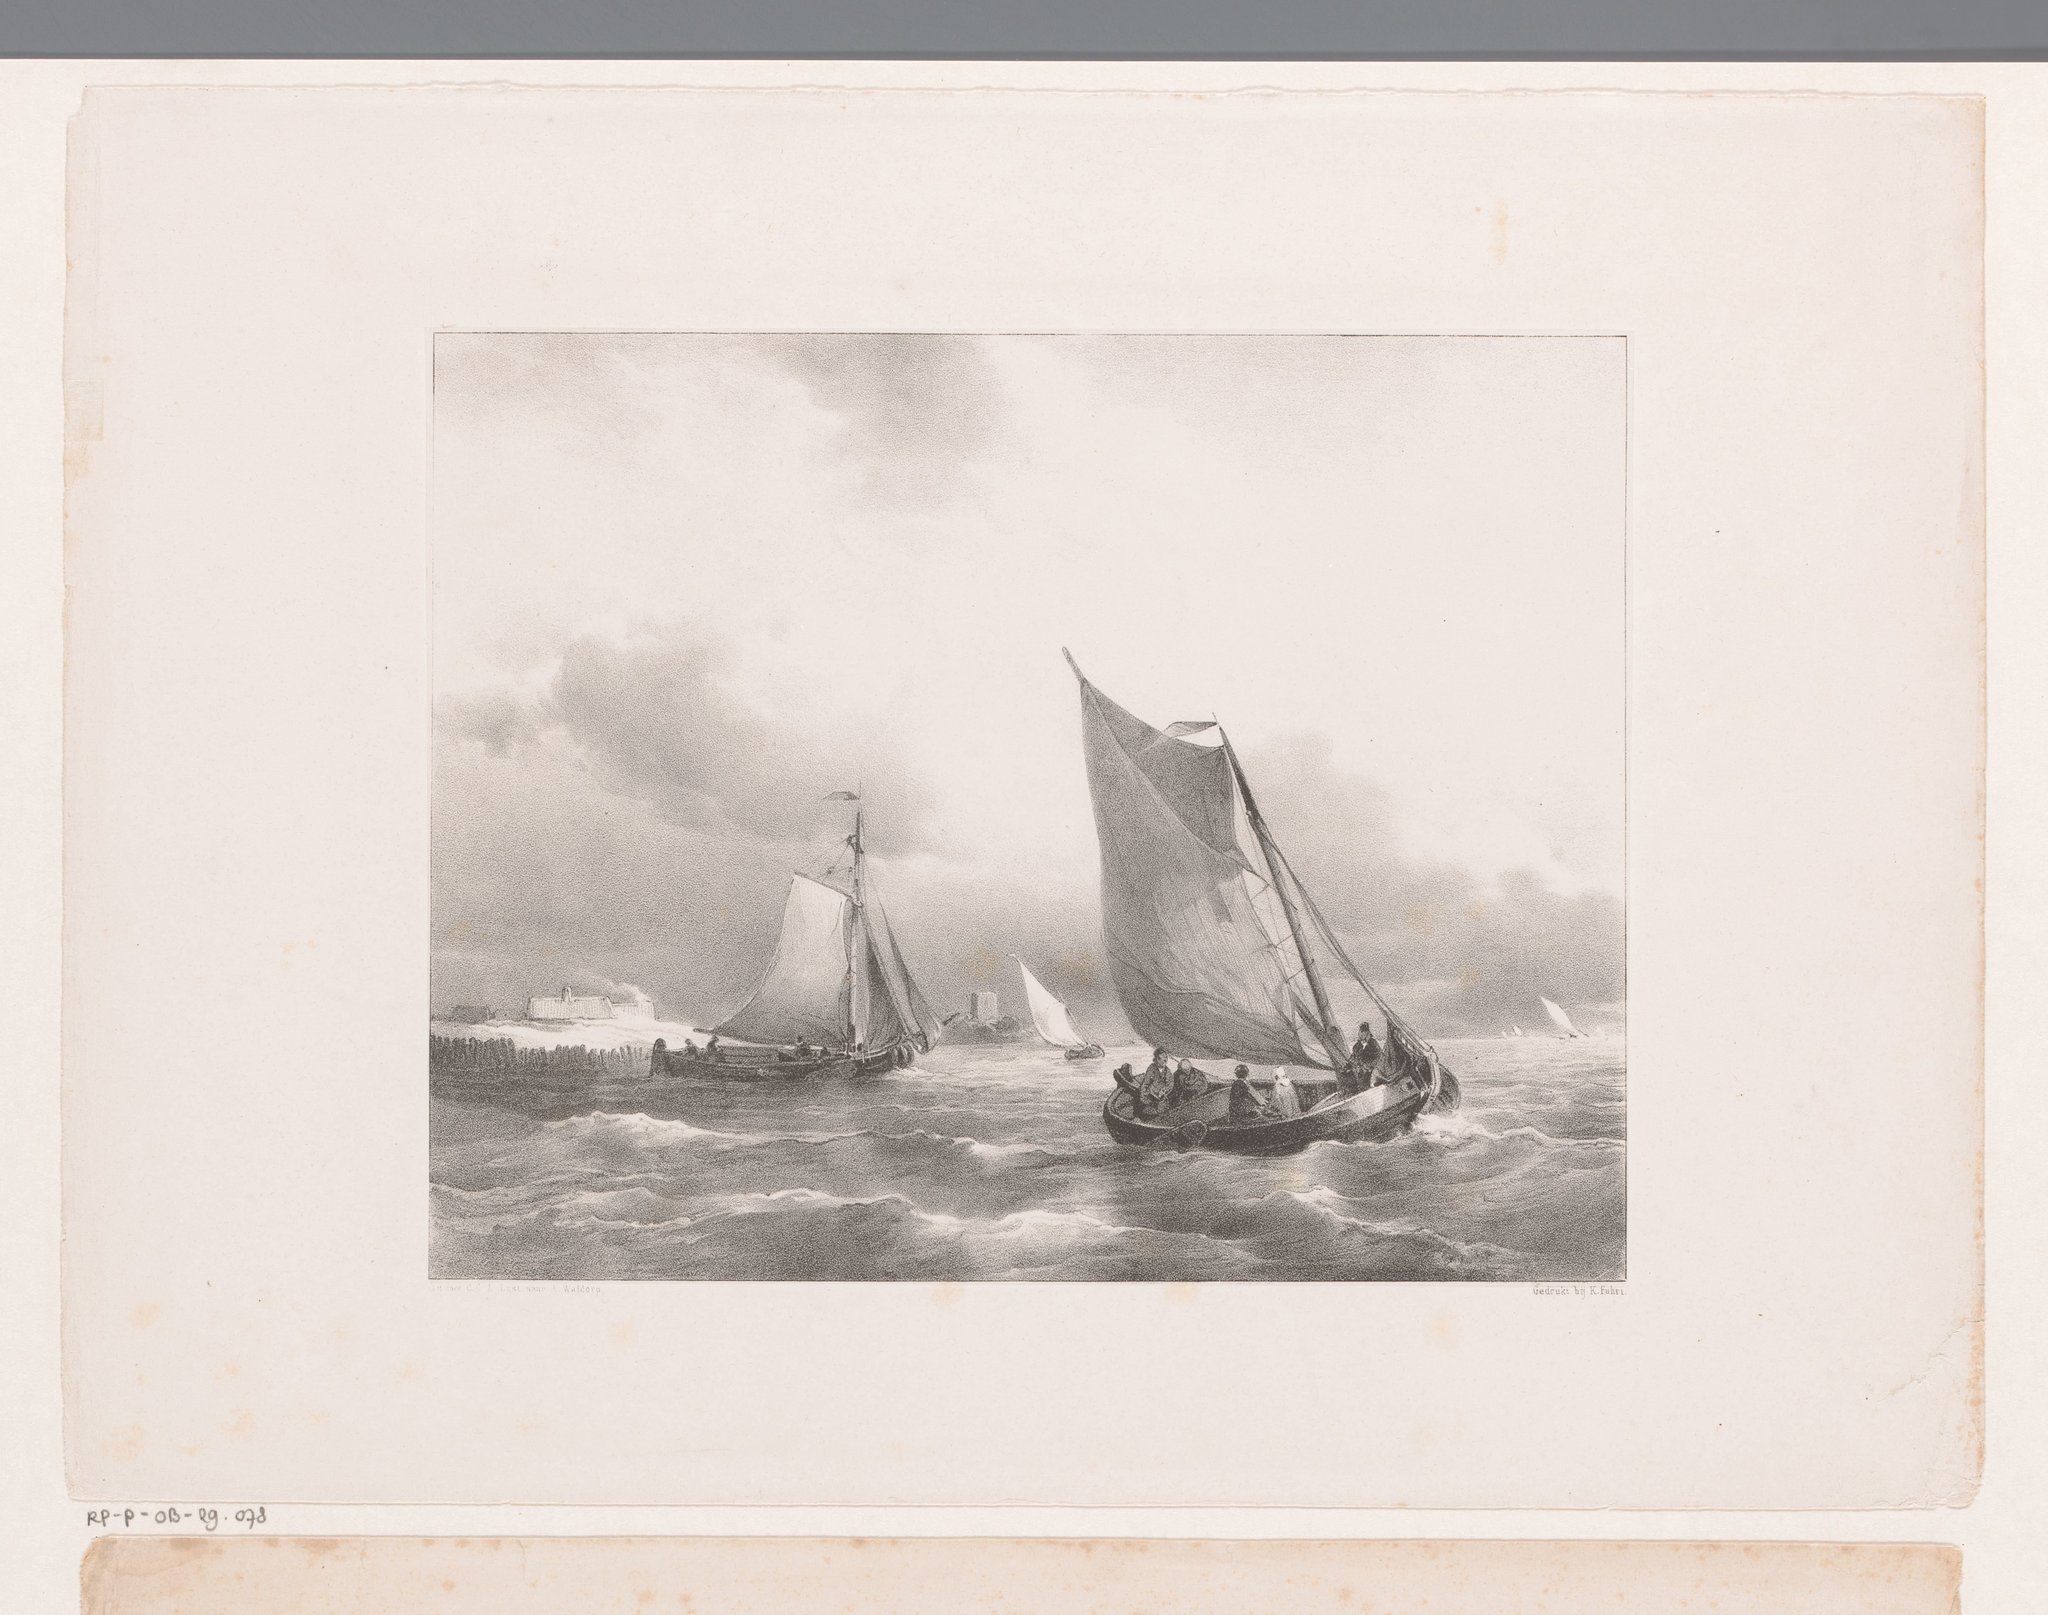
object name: print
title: Zeilschepen op zee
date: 1837-1853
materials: paper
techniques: lithograph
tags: sailing-ship, sailing-boat, sea (seascape)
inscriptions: collector's mark: Lugt 2228